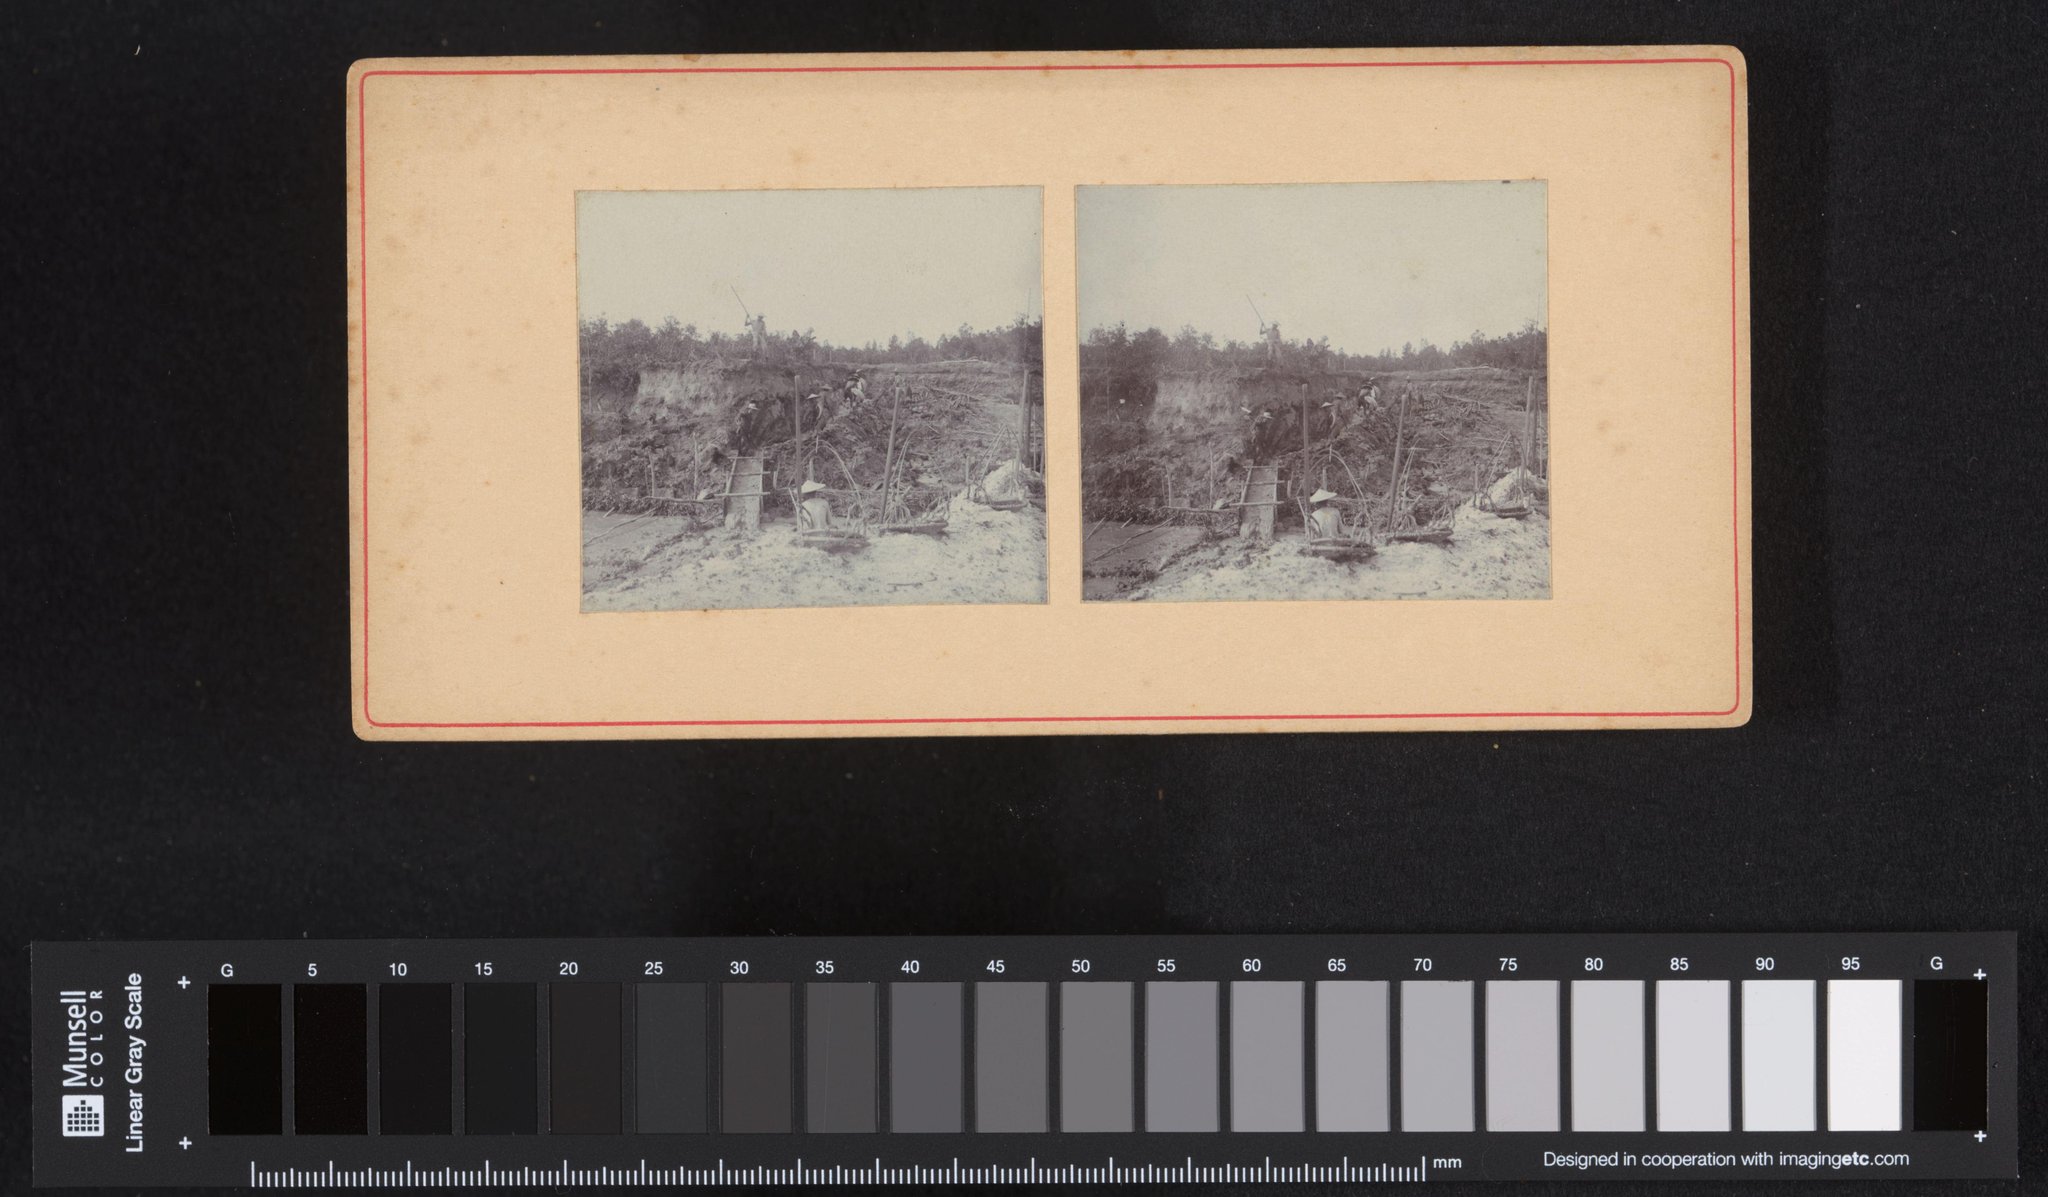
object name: stereograph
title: Tinmijn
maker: robert julius boers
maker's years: 1867-1932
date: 1900-1922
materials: cardboard, photographic support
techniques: gelatin silver print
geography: bangka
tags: robert julius boers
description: Arbeiders aan het werk in een open tinmijn op Banka. Onderdeel van een groep stereofoto's van Robert Julius Boers, chef van het staatsbedrijf de Banka-tinwinning op Banka, uit de periode ca. 1900-1922.